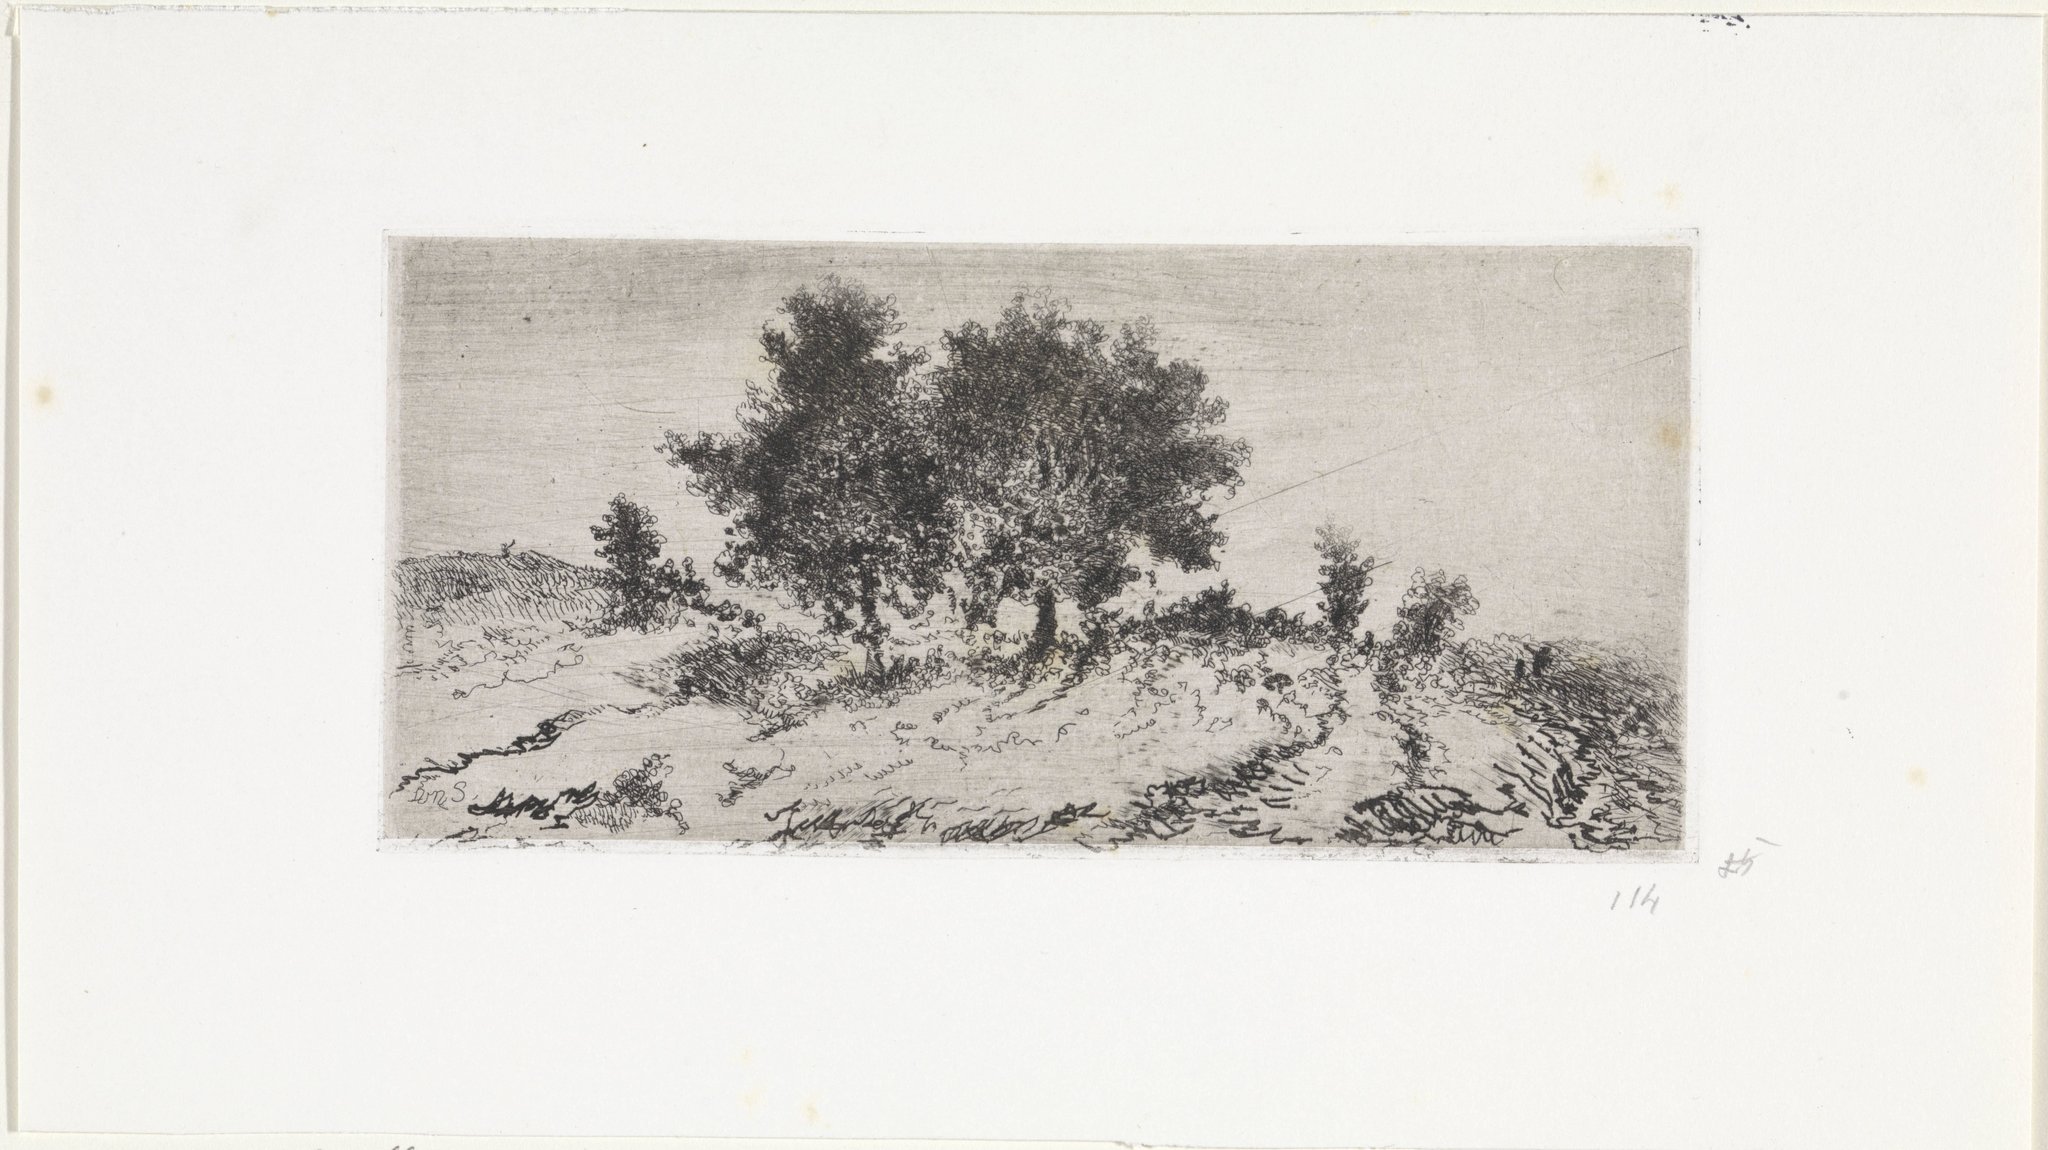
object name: print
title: Landschap met bomengroep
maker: arnoud schaepkens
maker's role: print maker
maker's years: 1816-1904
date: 1855-1904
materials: paper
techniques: drypoint, etching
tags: landscapes in the temperate zone - hh - ideal landscapes, trees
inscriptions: collector's mark: Lugt 2228